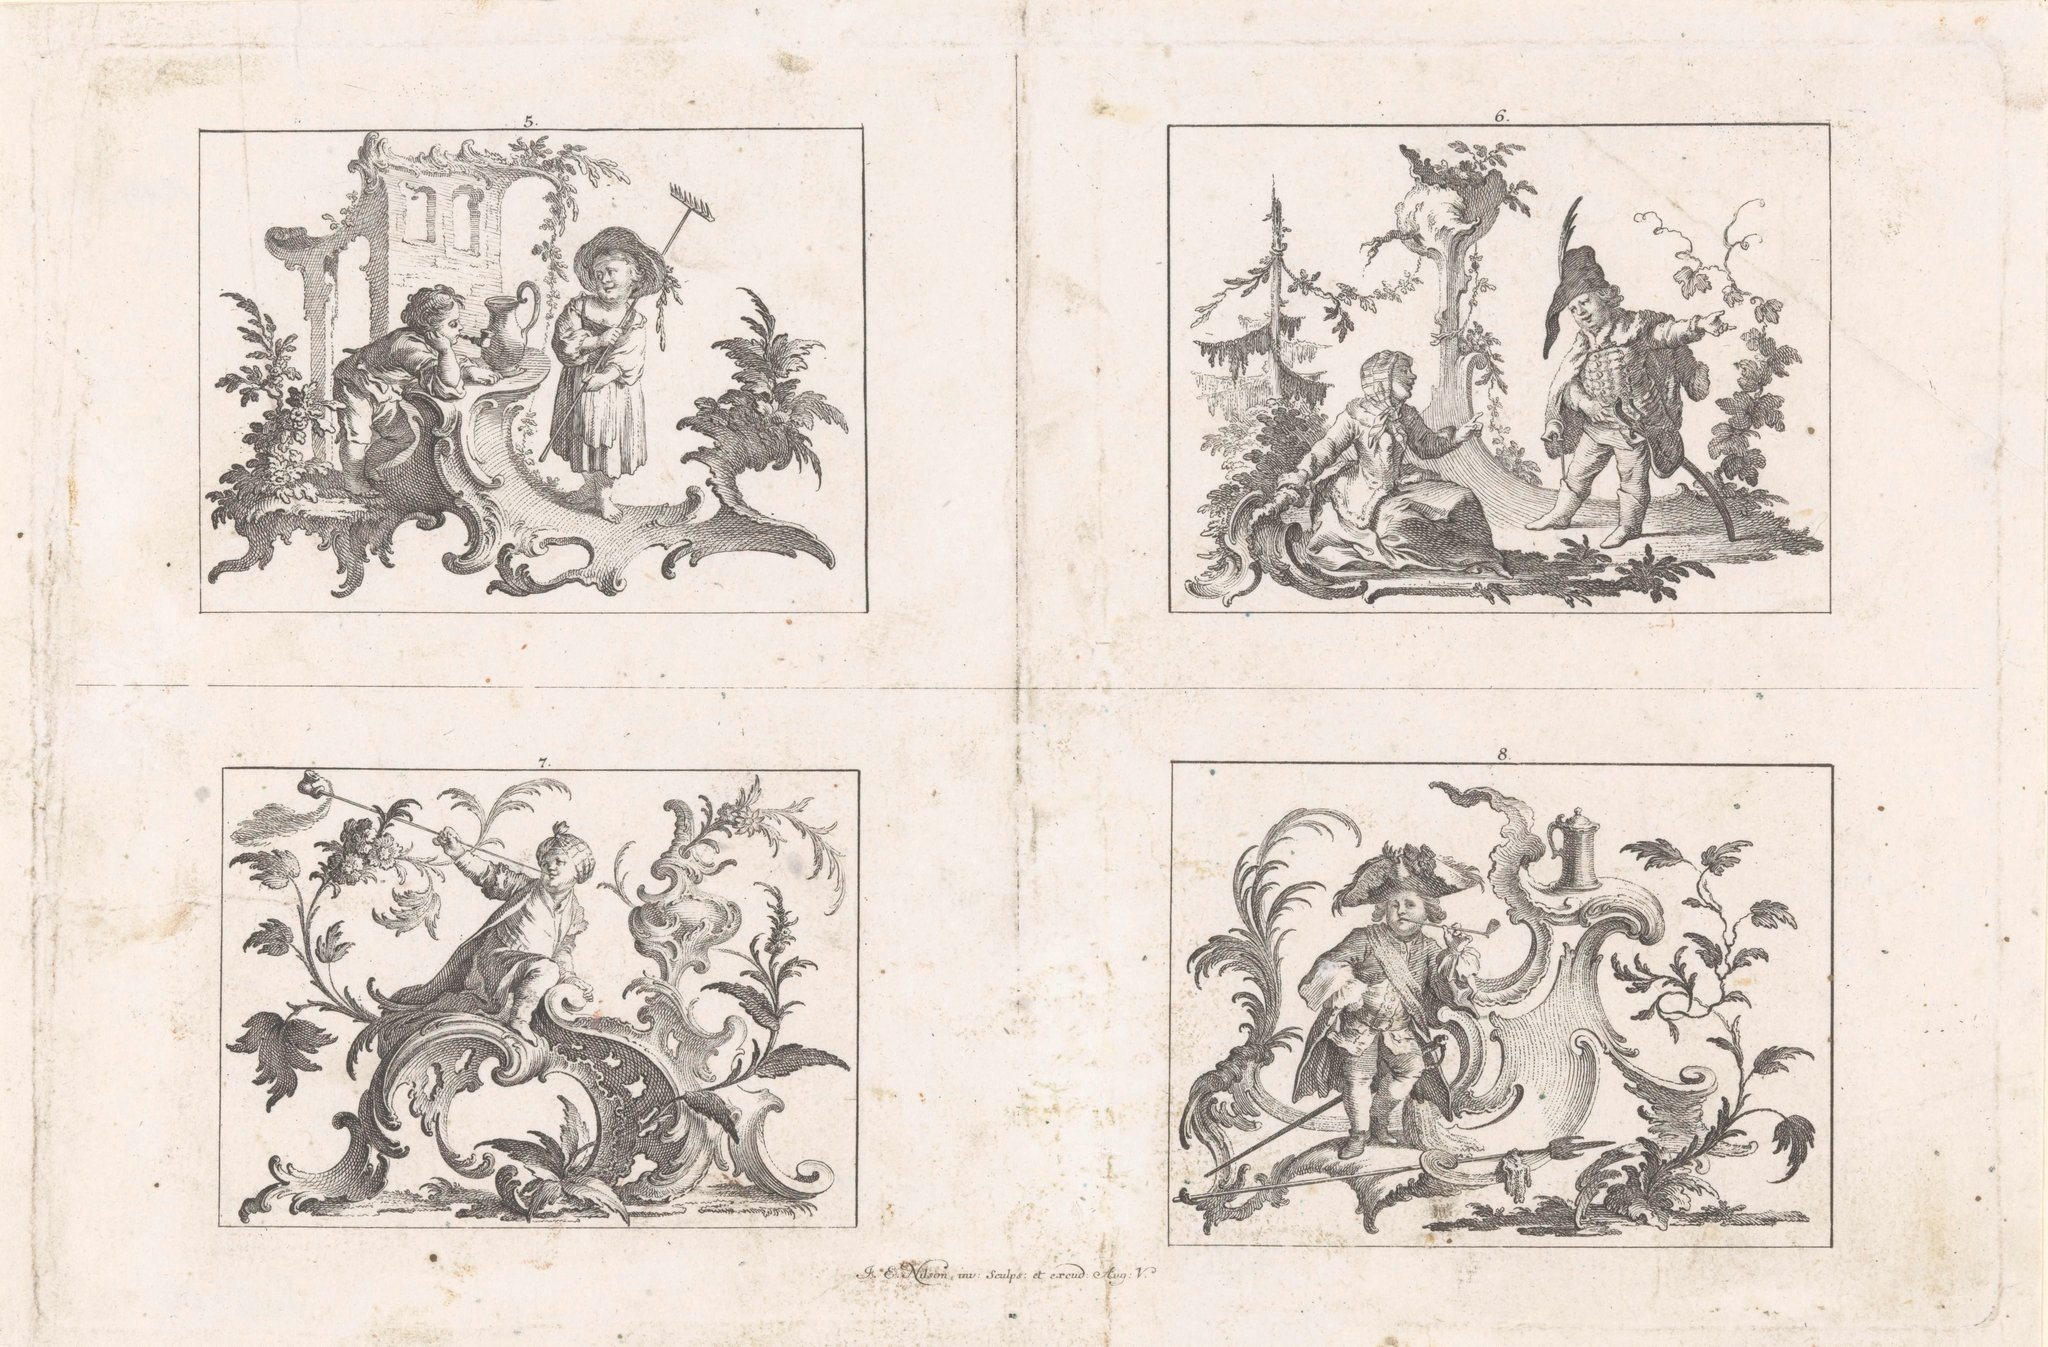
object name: print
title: Vier scènes met pijprokende mannen en vrouwen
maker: johann esaias nilson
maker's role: draughtsman, print maker, publisher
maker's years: 1721-1788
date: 1731-1788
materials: paper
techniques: engraving, etching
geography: augsburg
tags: pipe ~ tobacco (+ taking (particular) foodstuffs: eating, drinking, smoking, chewing, etc.)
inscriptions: collector's mark: Lugt 2228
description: Vier scènes op een blad, genummerd 5-8. Links boven een man met een pijp en rechts een vrouw met een hark. Rechts boven een man en vrouw in gesprek. Links onder een man met een tulband met een lange pijp op een rocaille ornament. Rechts onder een man met een pijp naast een rocaille ornament met een bierpul.